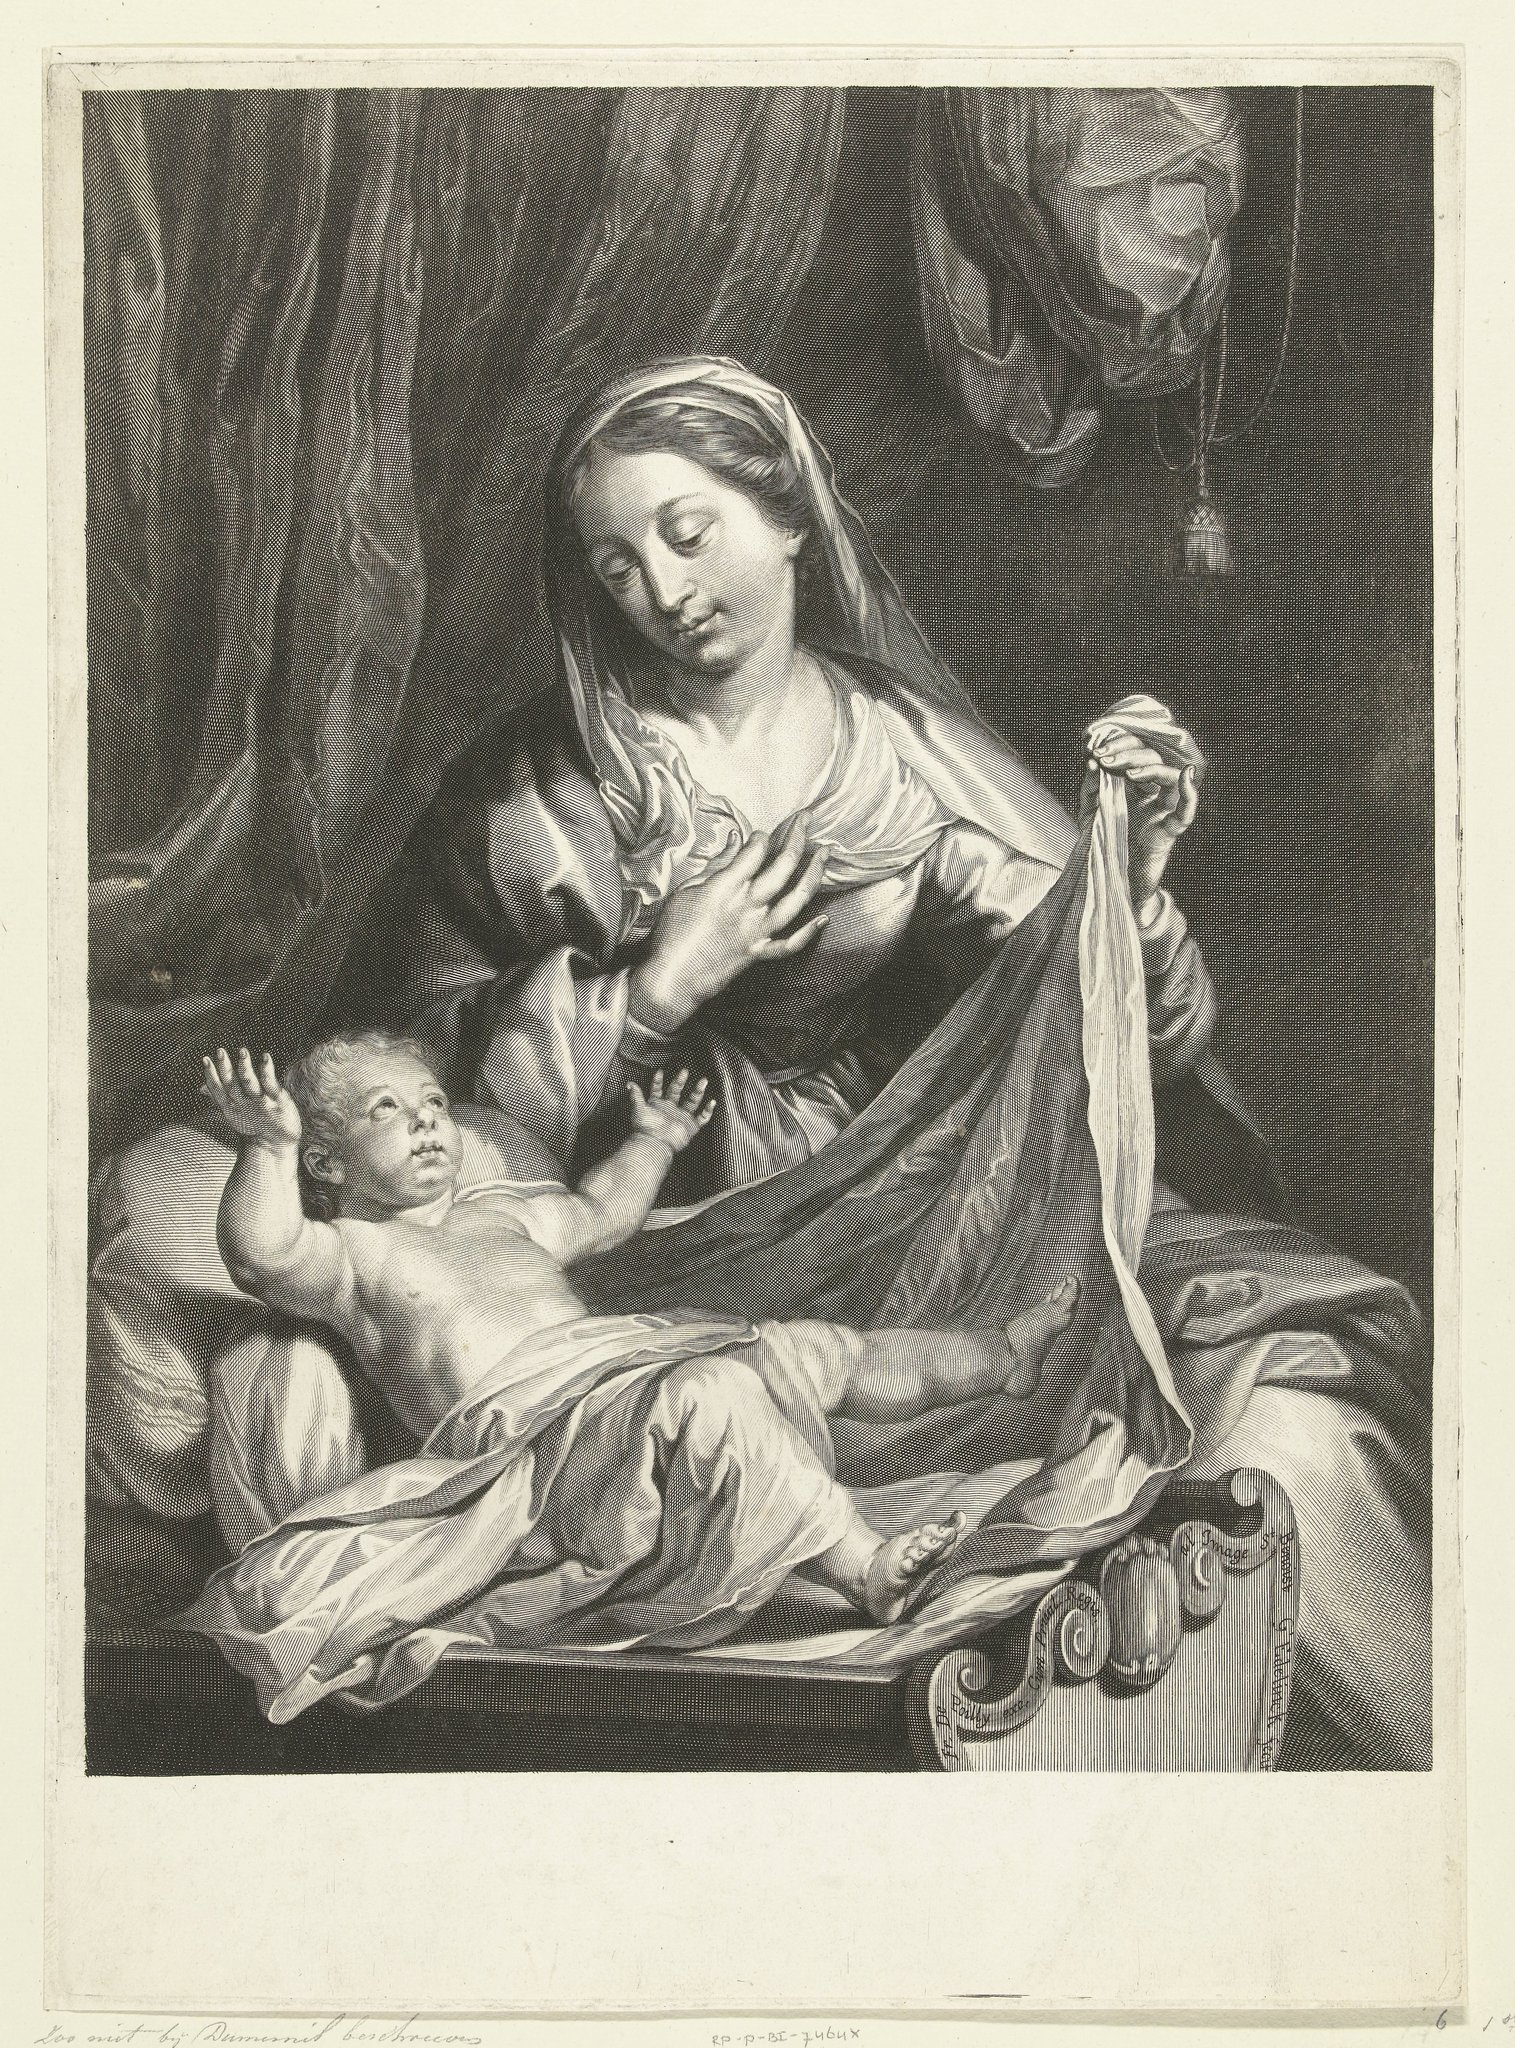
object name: print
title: Maria met Christuskind in kribbe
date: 1666-1707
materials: paper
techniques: engraving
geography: paris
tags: madonna: i.e. mary with the christ-child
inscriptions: collector's mark: Lugt 240